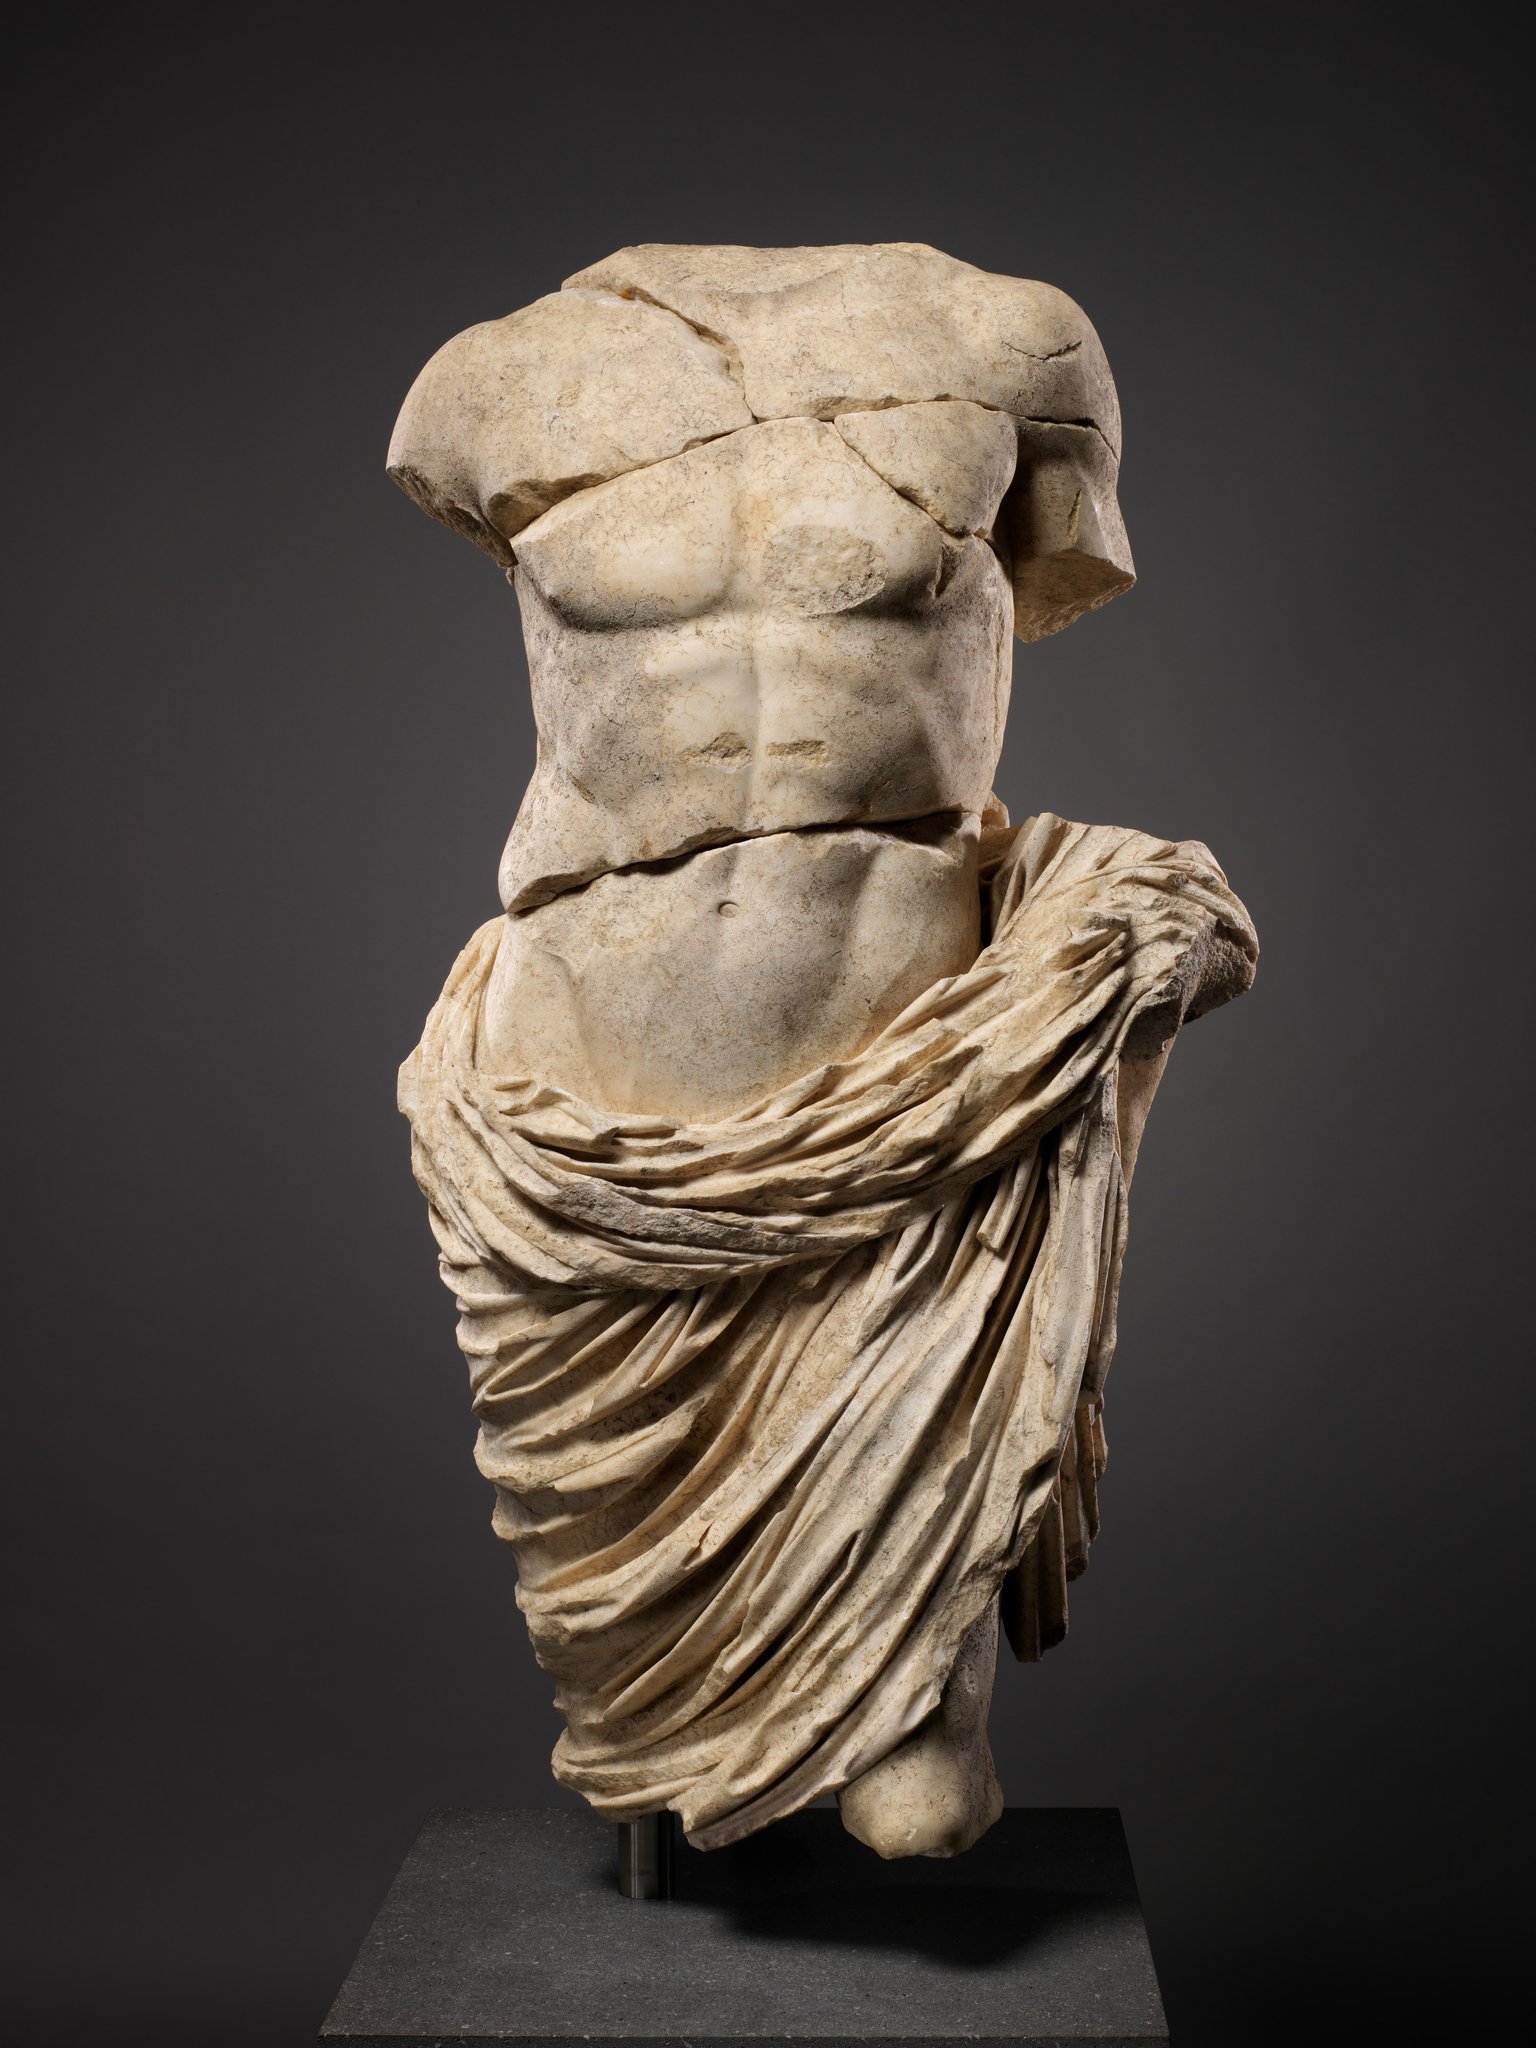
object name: statue of a young man, half draped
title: Marble statue of a member of the imperial family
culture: roman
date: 27 BCE-68 CE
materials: marble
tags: men